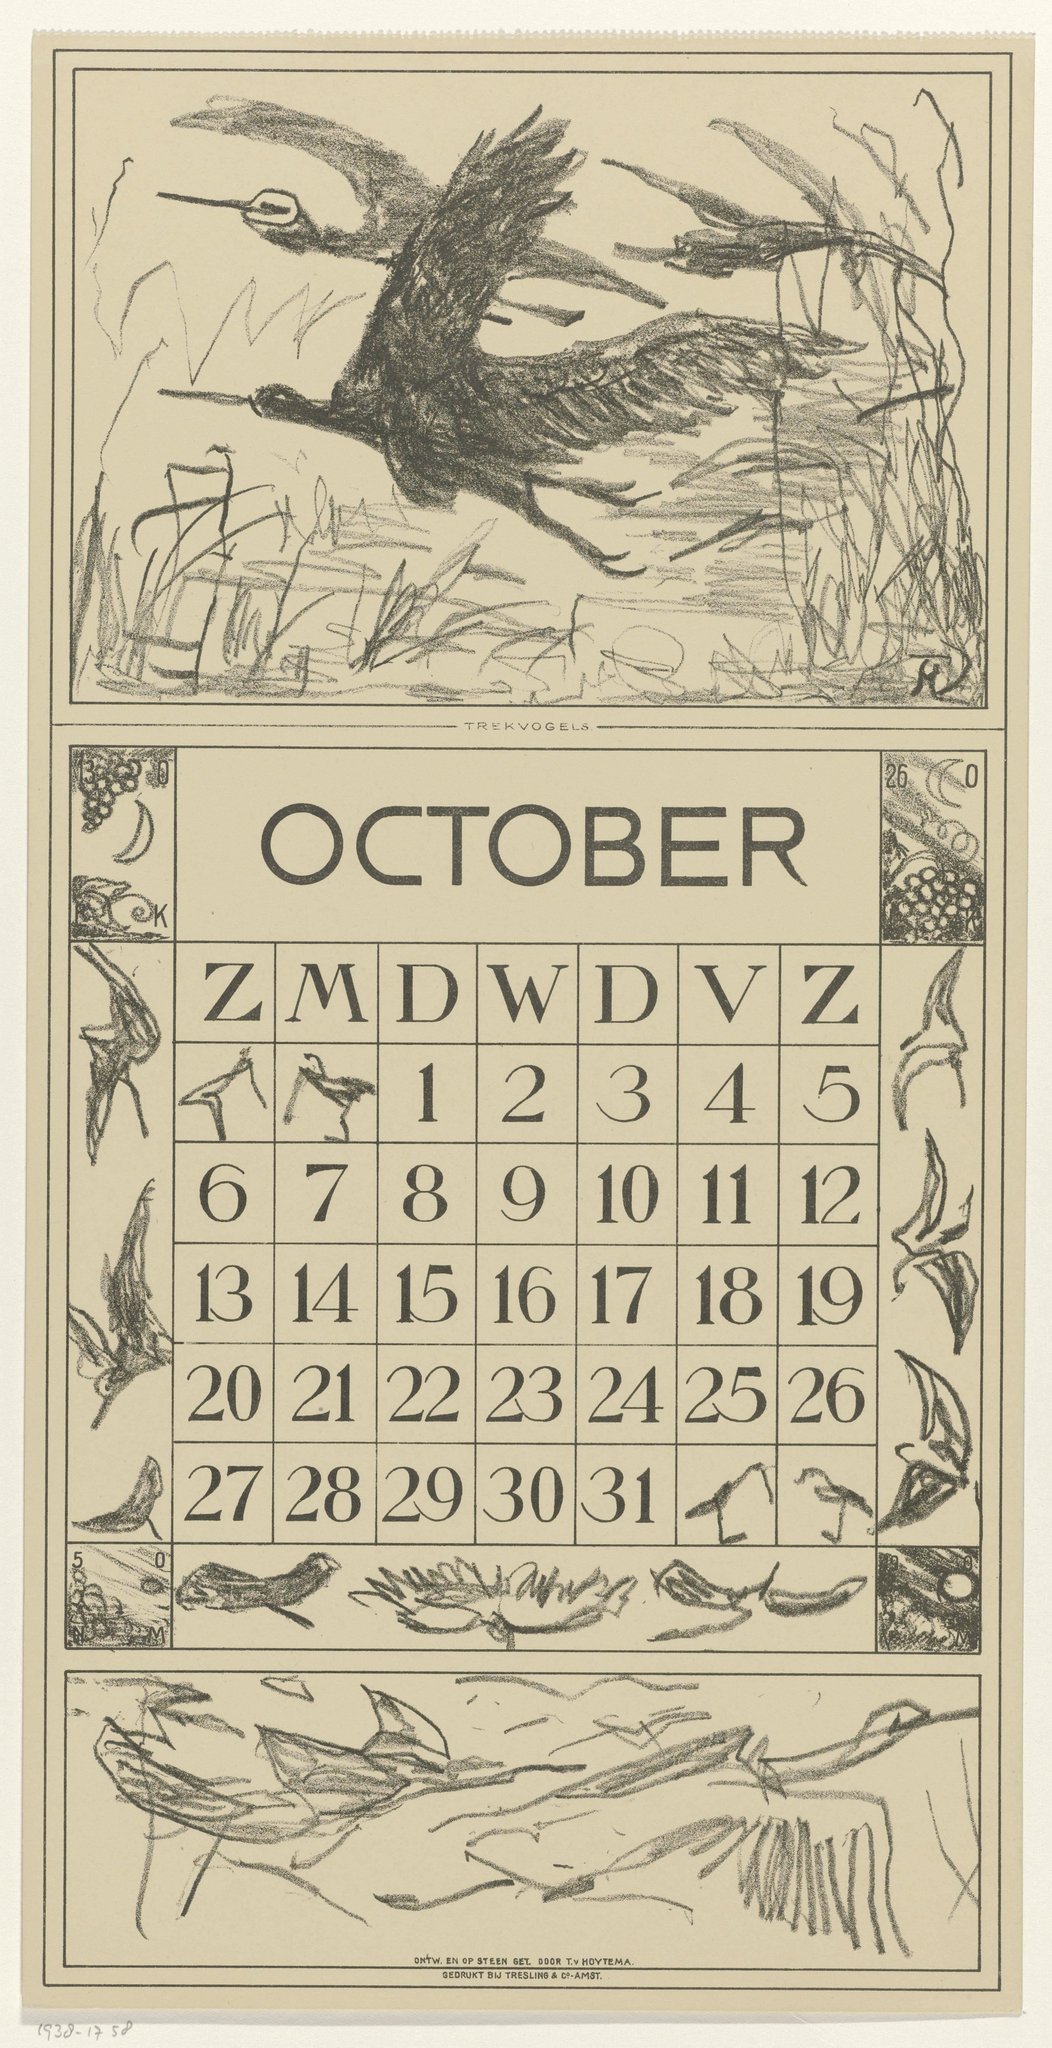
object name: calendar leaf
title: Kalender 1918 12 lithografien door Th. v. Hoytema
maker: theo van hoytema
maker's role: draughtsman, painter, print maker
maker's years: 1863-1917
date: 1917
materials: paper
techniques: lithograph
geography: amsterdam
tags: birds, lunar year, october ~ other concepts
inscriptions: collector's mark: Lugt 2228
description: In de hoeken de standen van de maan op vier dagen. Bovenaan het blad een scheurlijn.